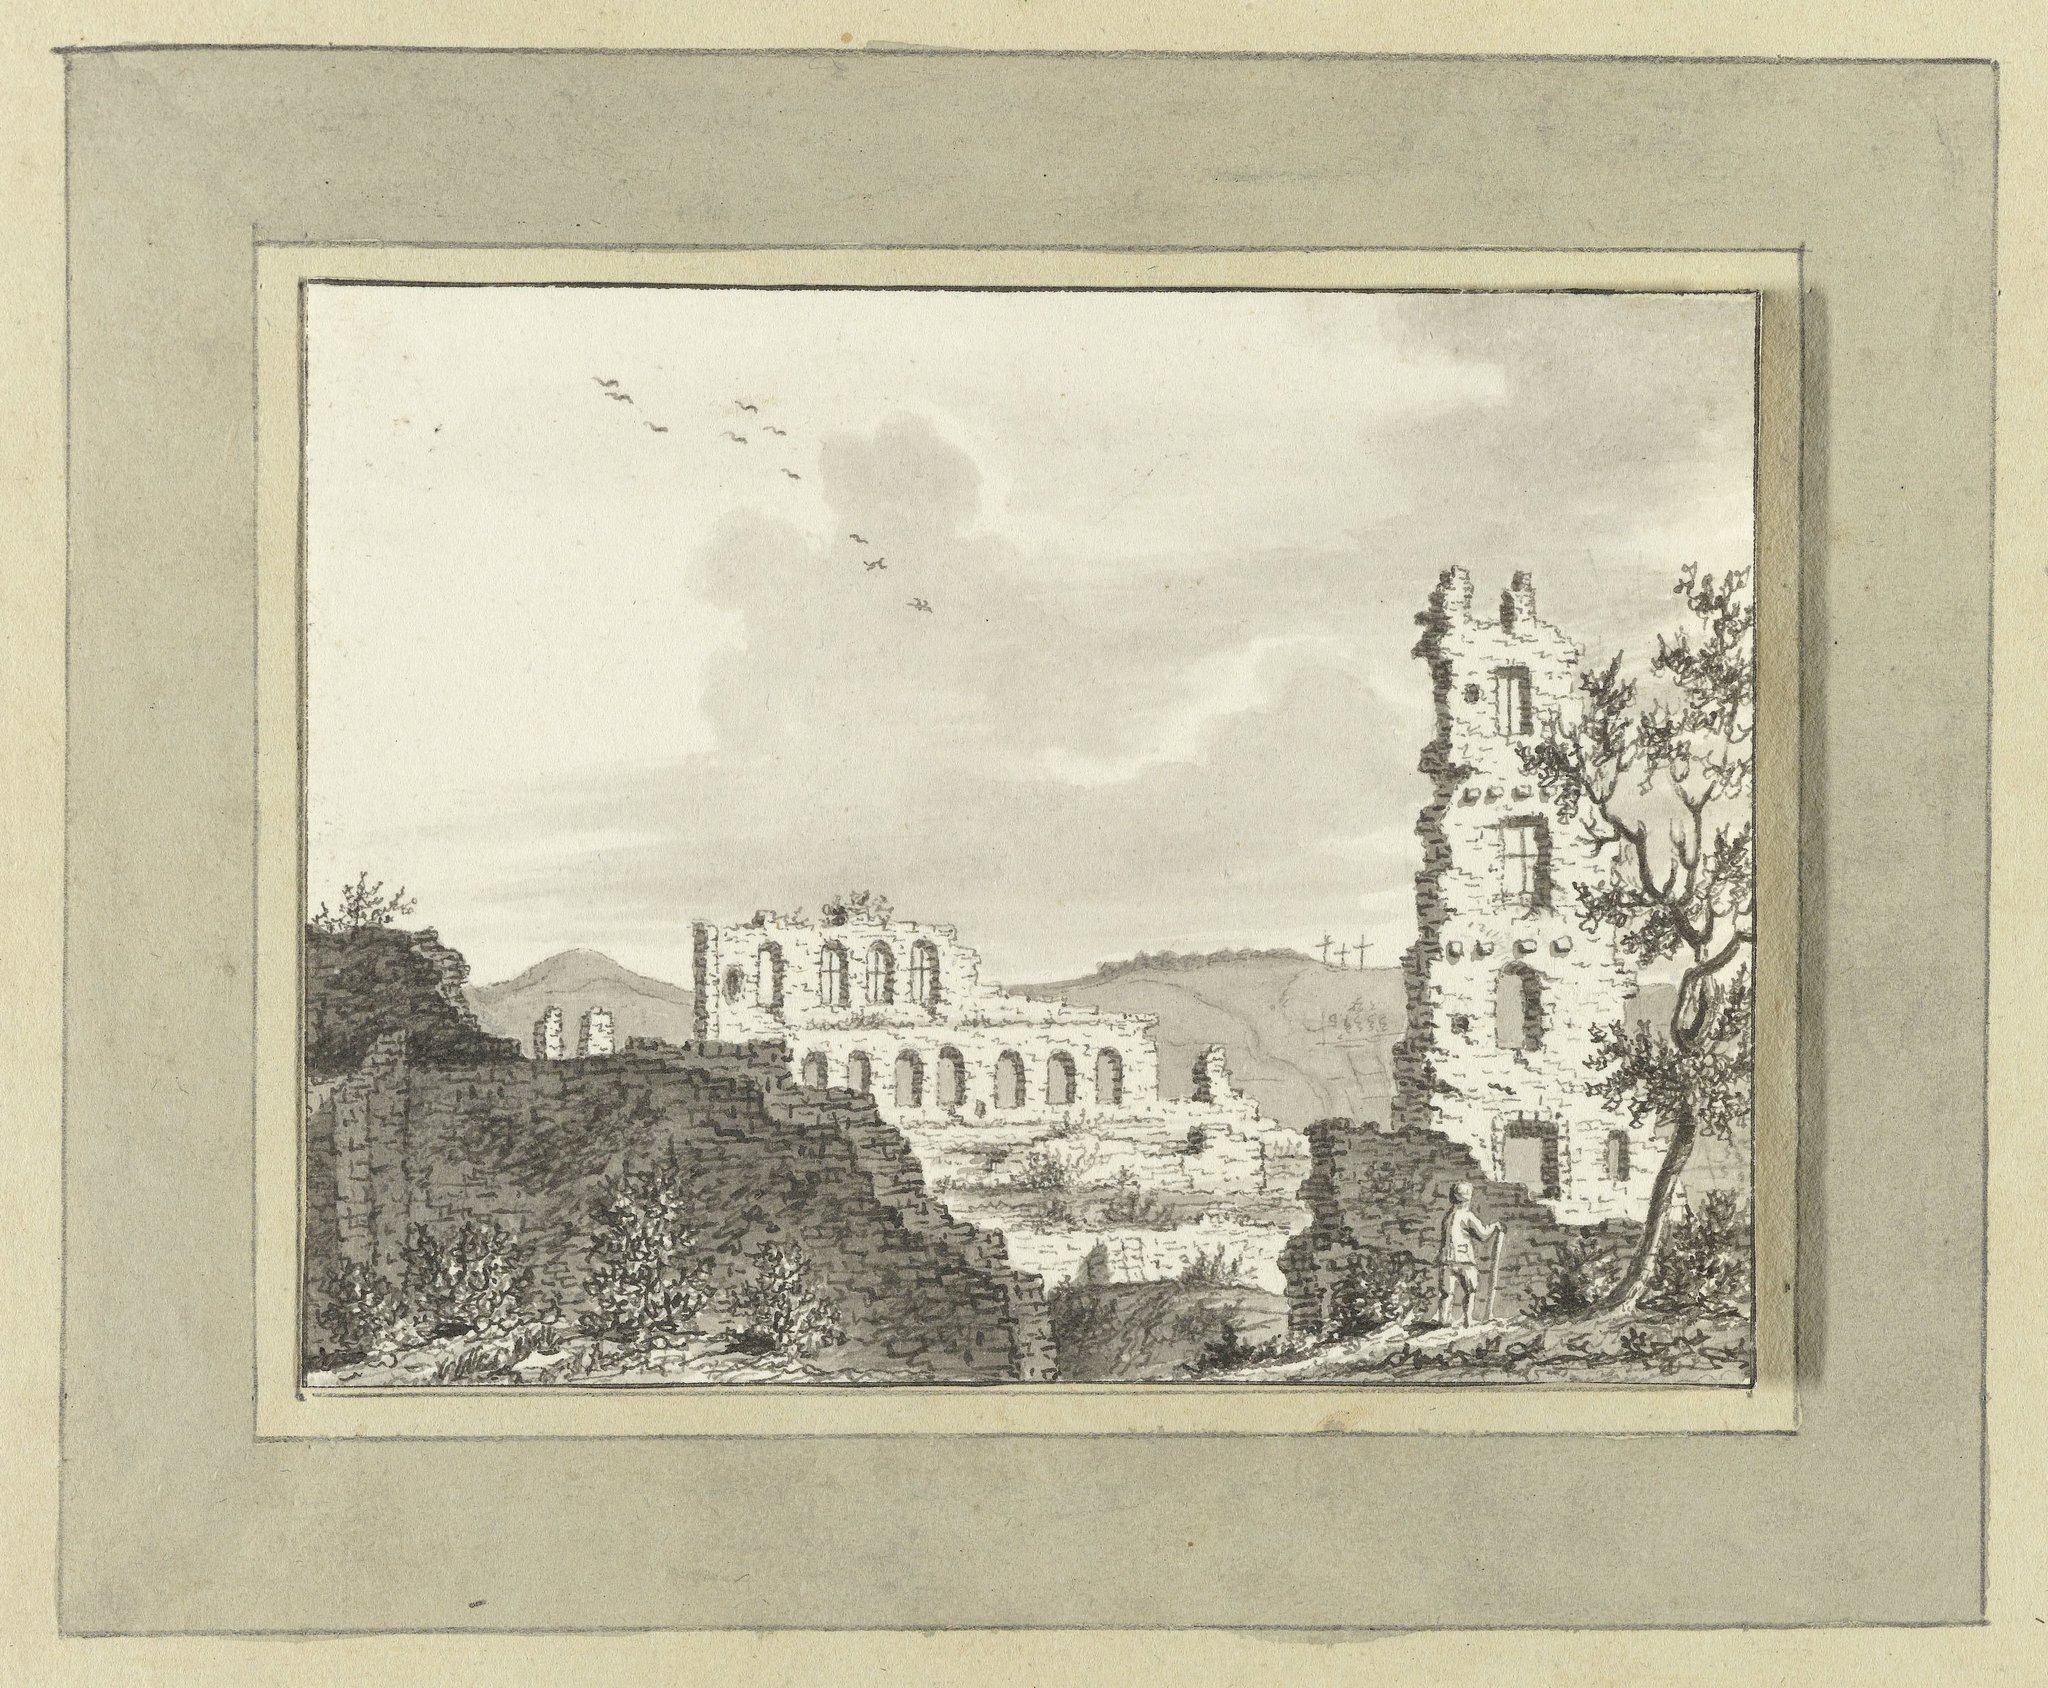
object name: drawing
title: Ruïne van Carlburg bij Carlstadt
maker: ernst willem jan bagelaar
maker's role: draughtsman, print maker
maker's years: 1775-1837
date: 1801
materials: paper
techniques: brush, pen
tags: landscape with ruins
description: Tekening uit album met 13 tekeningen gemaakt in Duitsland door kapitein Bagelaar, gedurende de veldtocht van 1800.